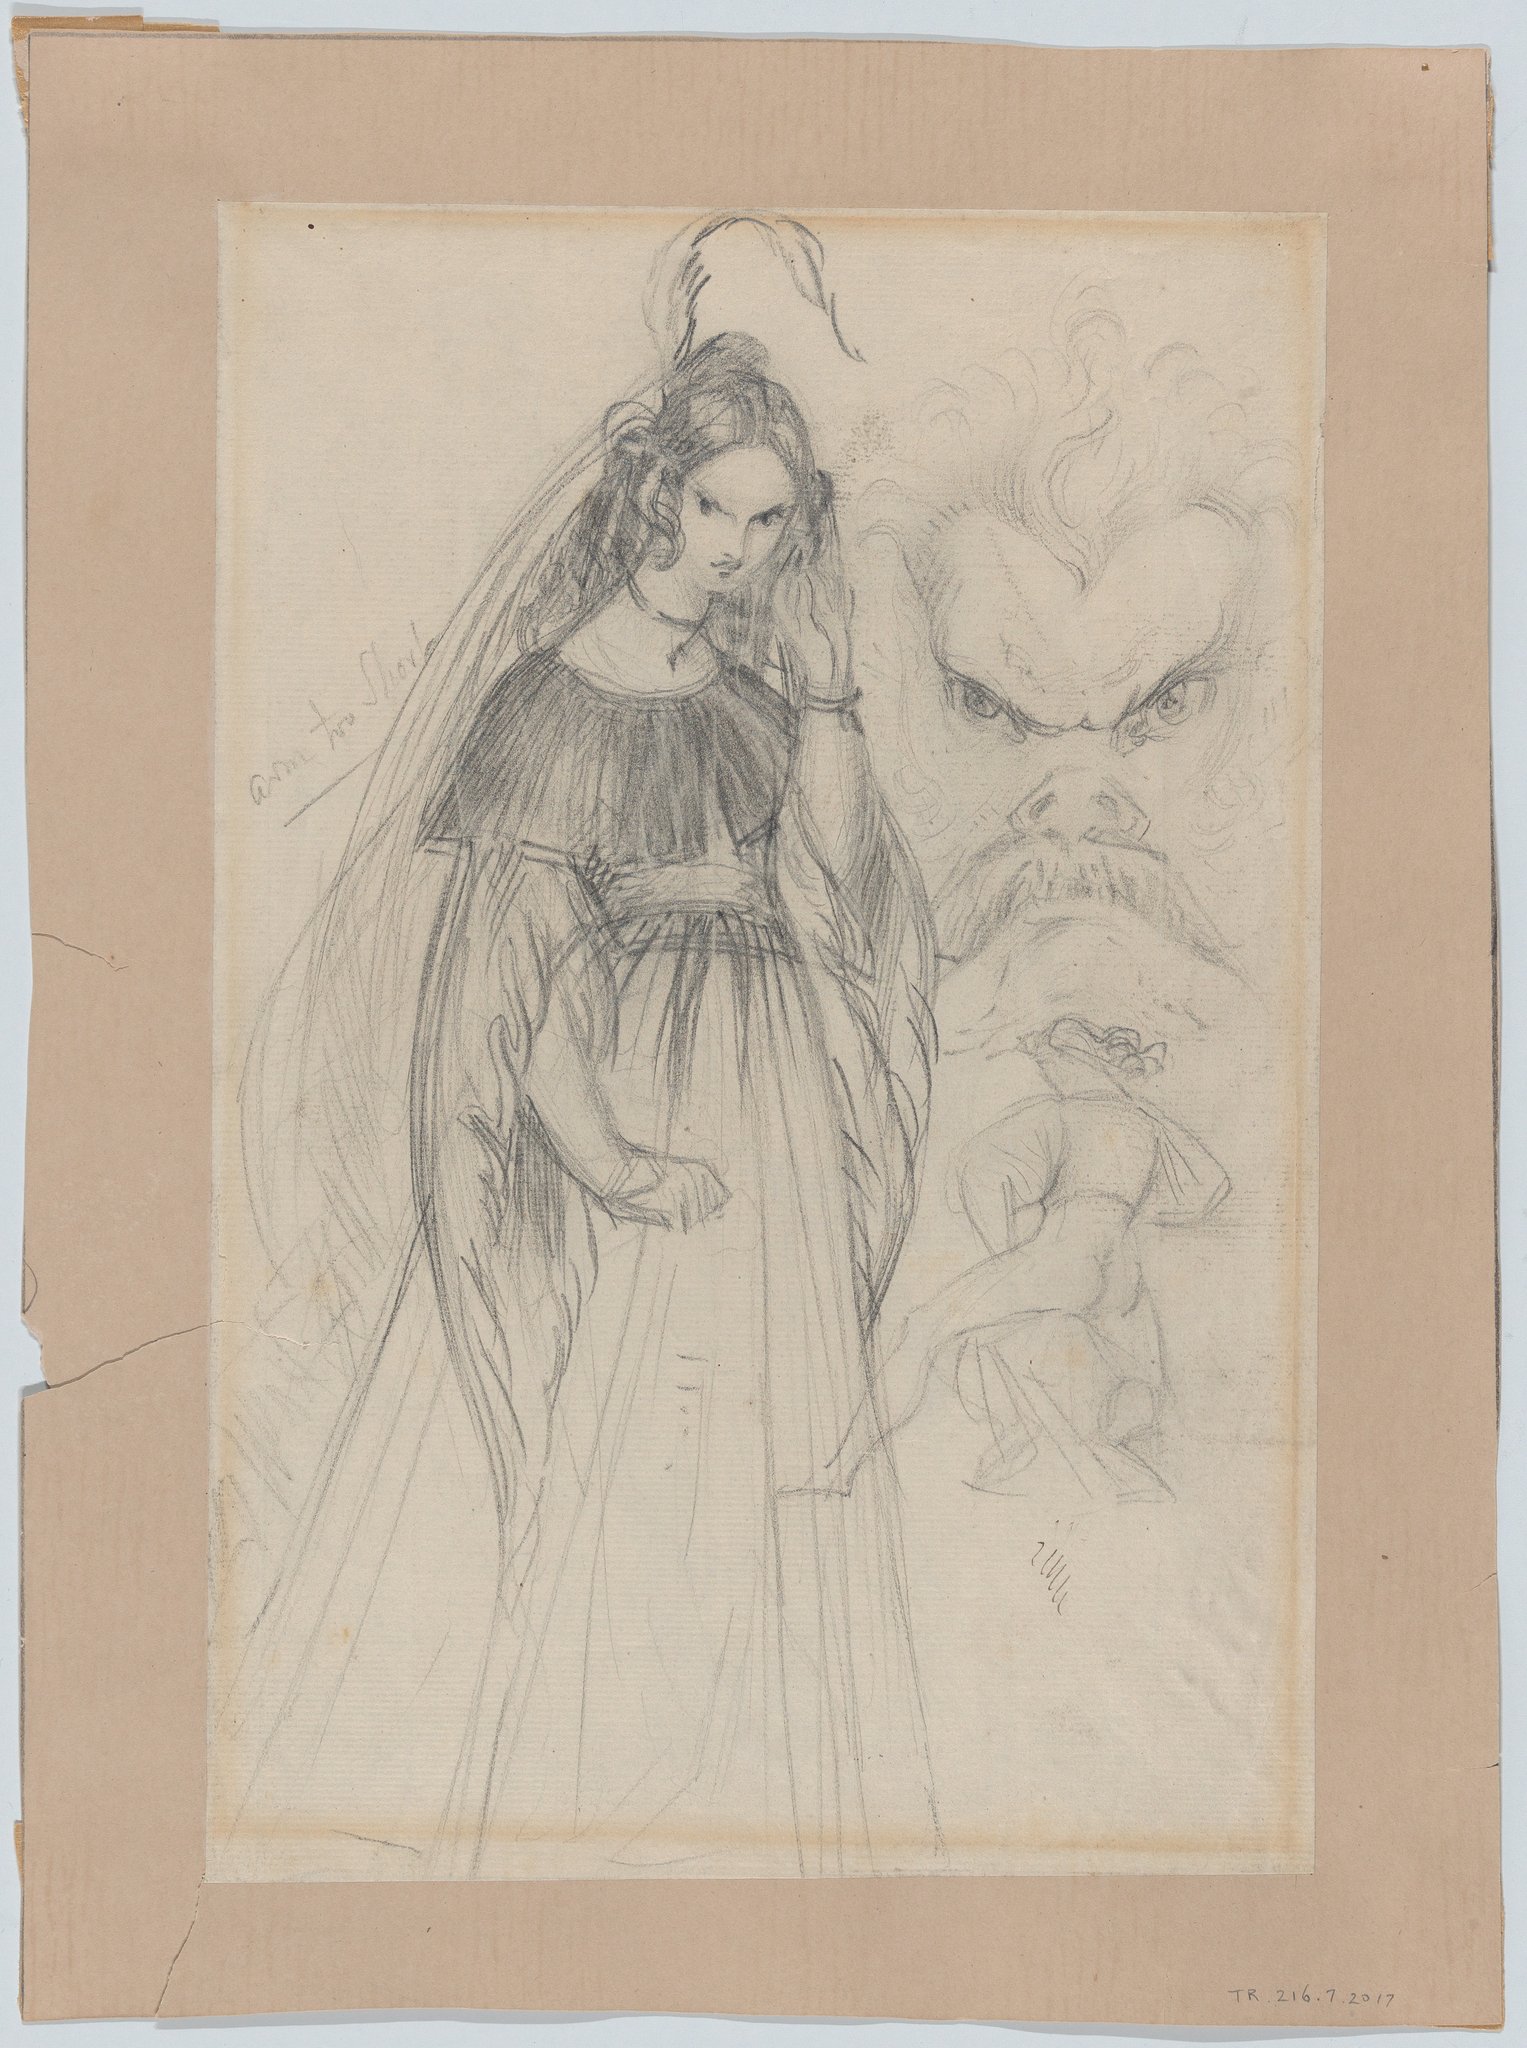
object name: drawing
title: A Femme Fatale, a mask-like male face, and male figure seen from behind (recto). An angel descending stairs (verso)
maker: theodor richard edward von holst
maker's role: artist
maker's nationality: british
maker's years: 1810-1844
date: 1836-1844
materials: graphite